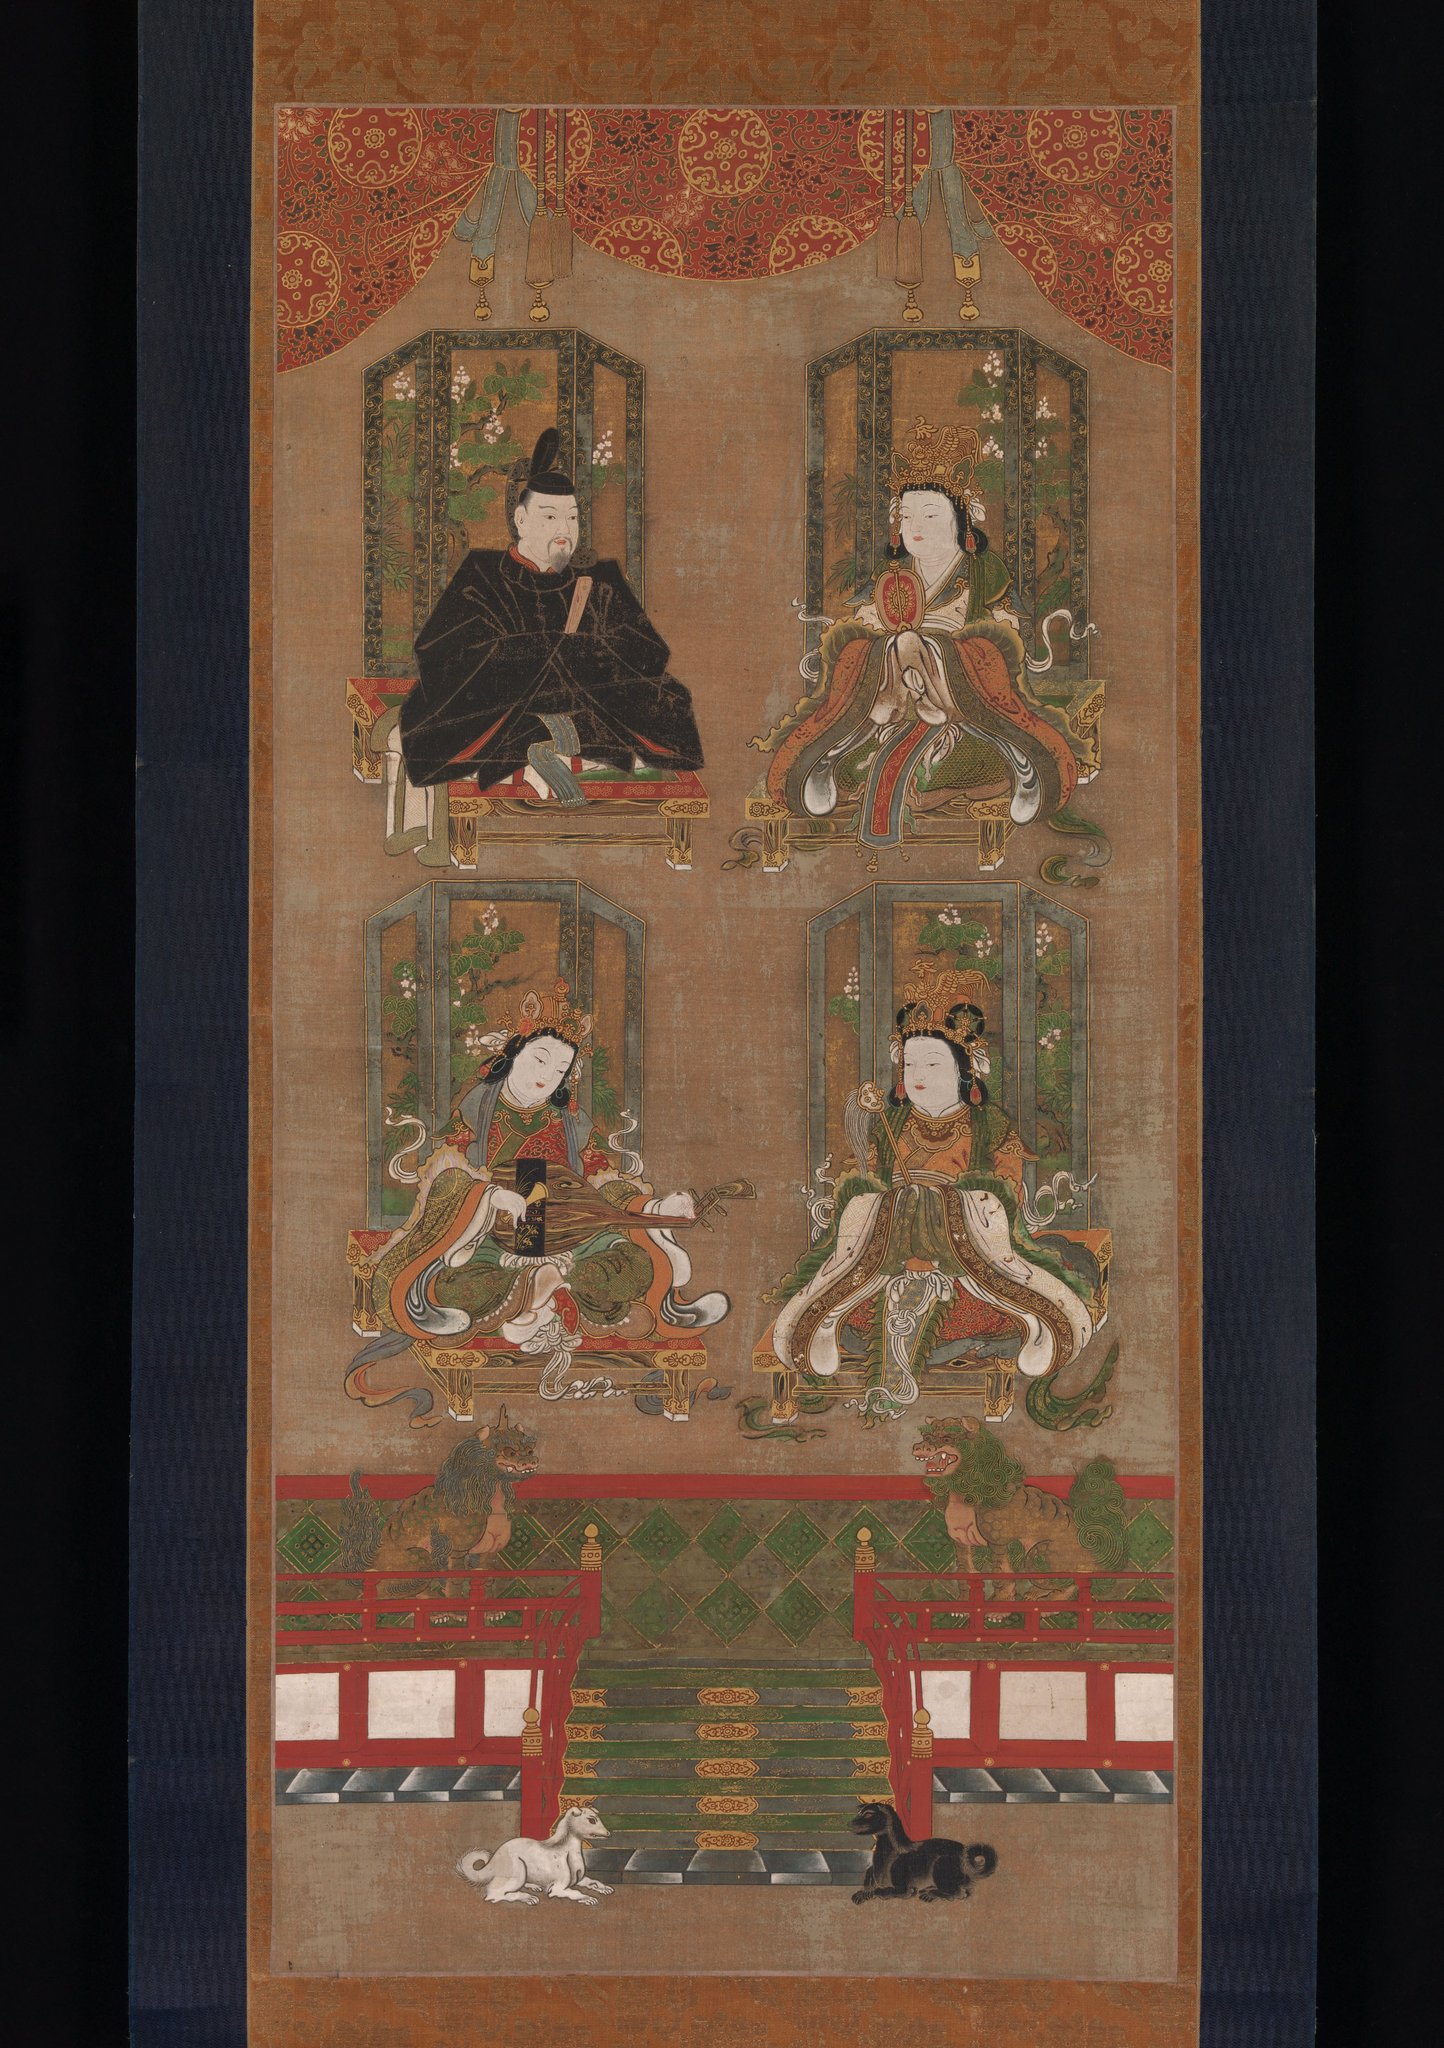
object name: hanging scroll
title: The Four Deities of Mount Kōya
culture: japanese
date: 1501-1600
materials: gold, ink, silk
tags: musical instruments,animals,men,women,deities